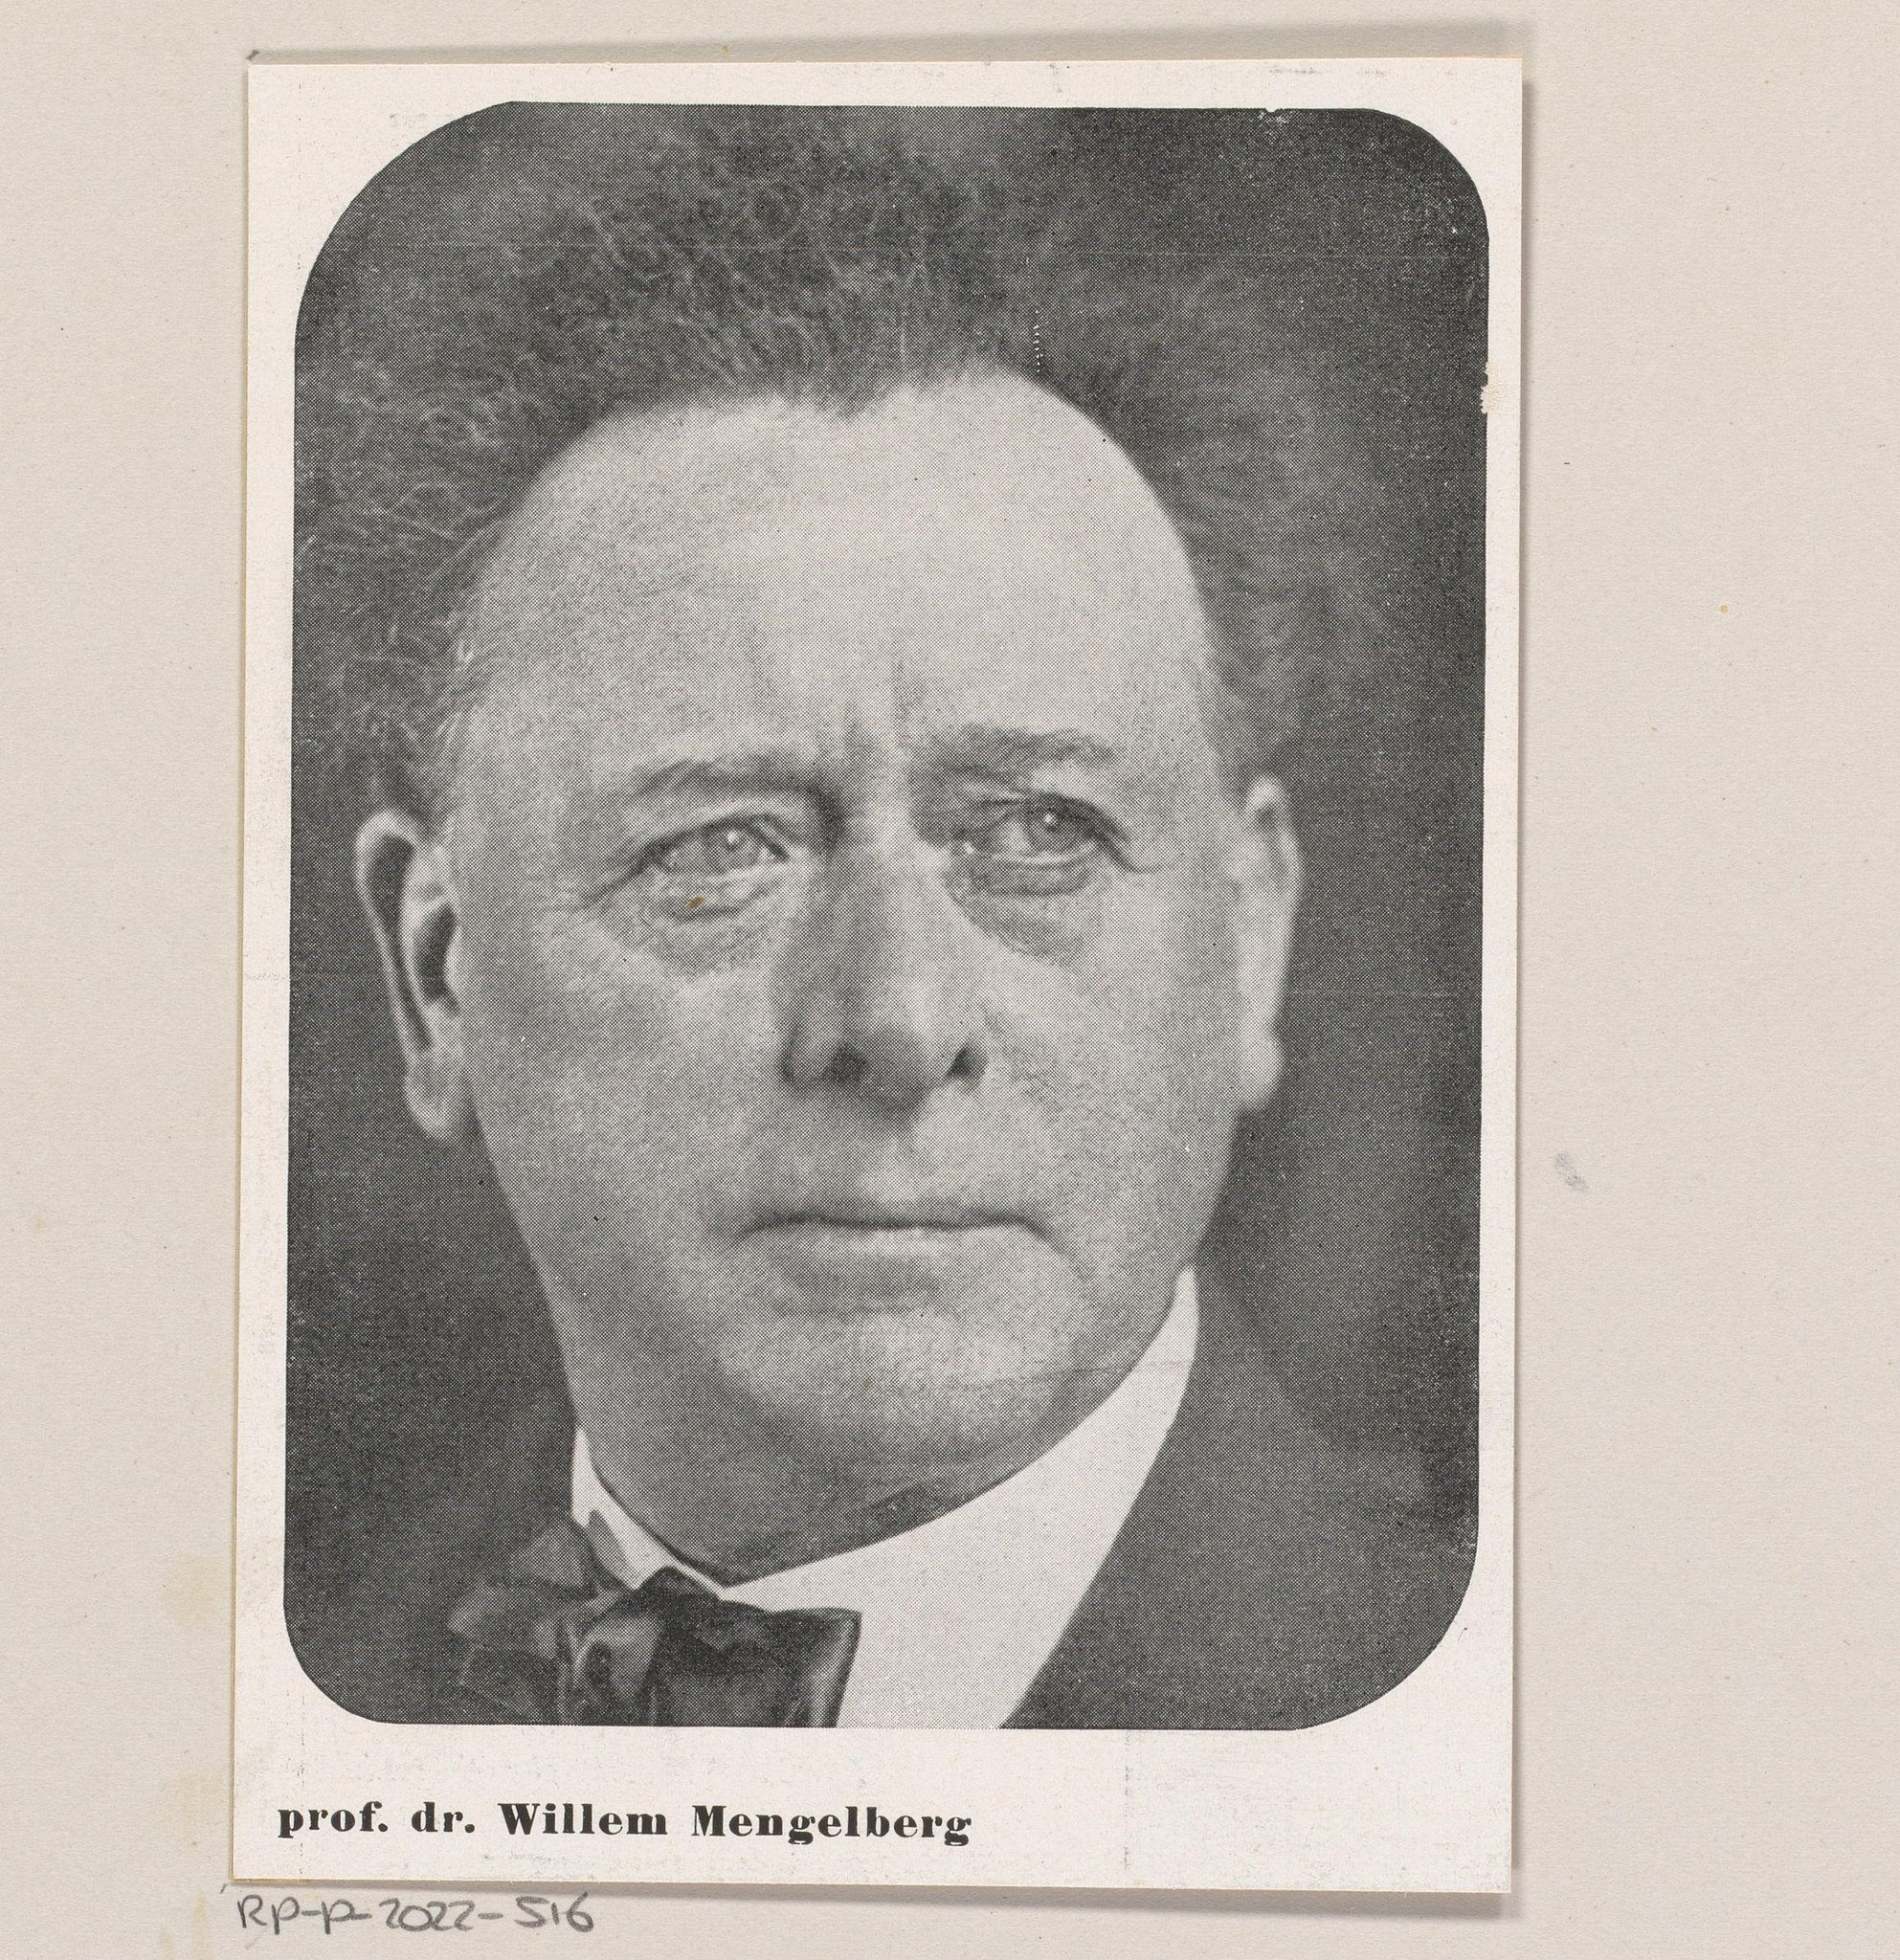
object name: photomechanical print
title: Portret van Willem Mengelberg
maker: Anonymous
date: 1910-1970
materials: paper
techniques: autotype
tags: utrecht, historical persons, conductor ~ music